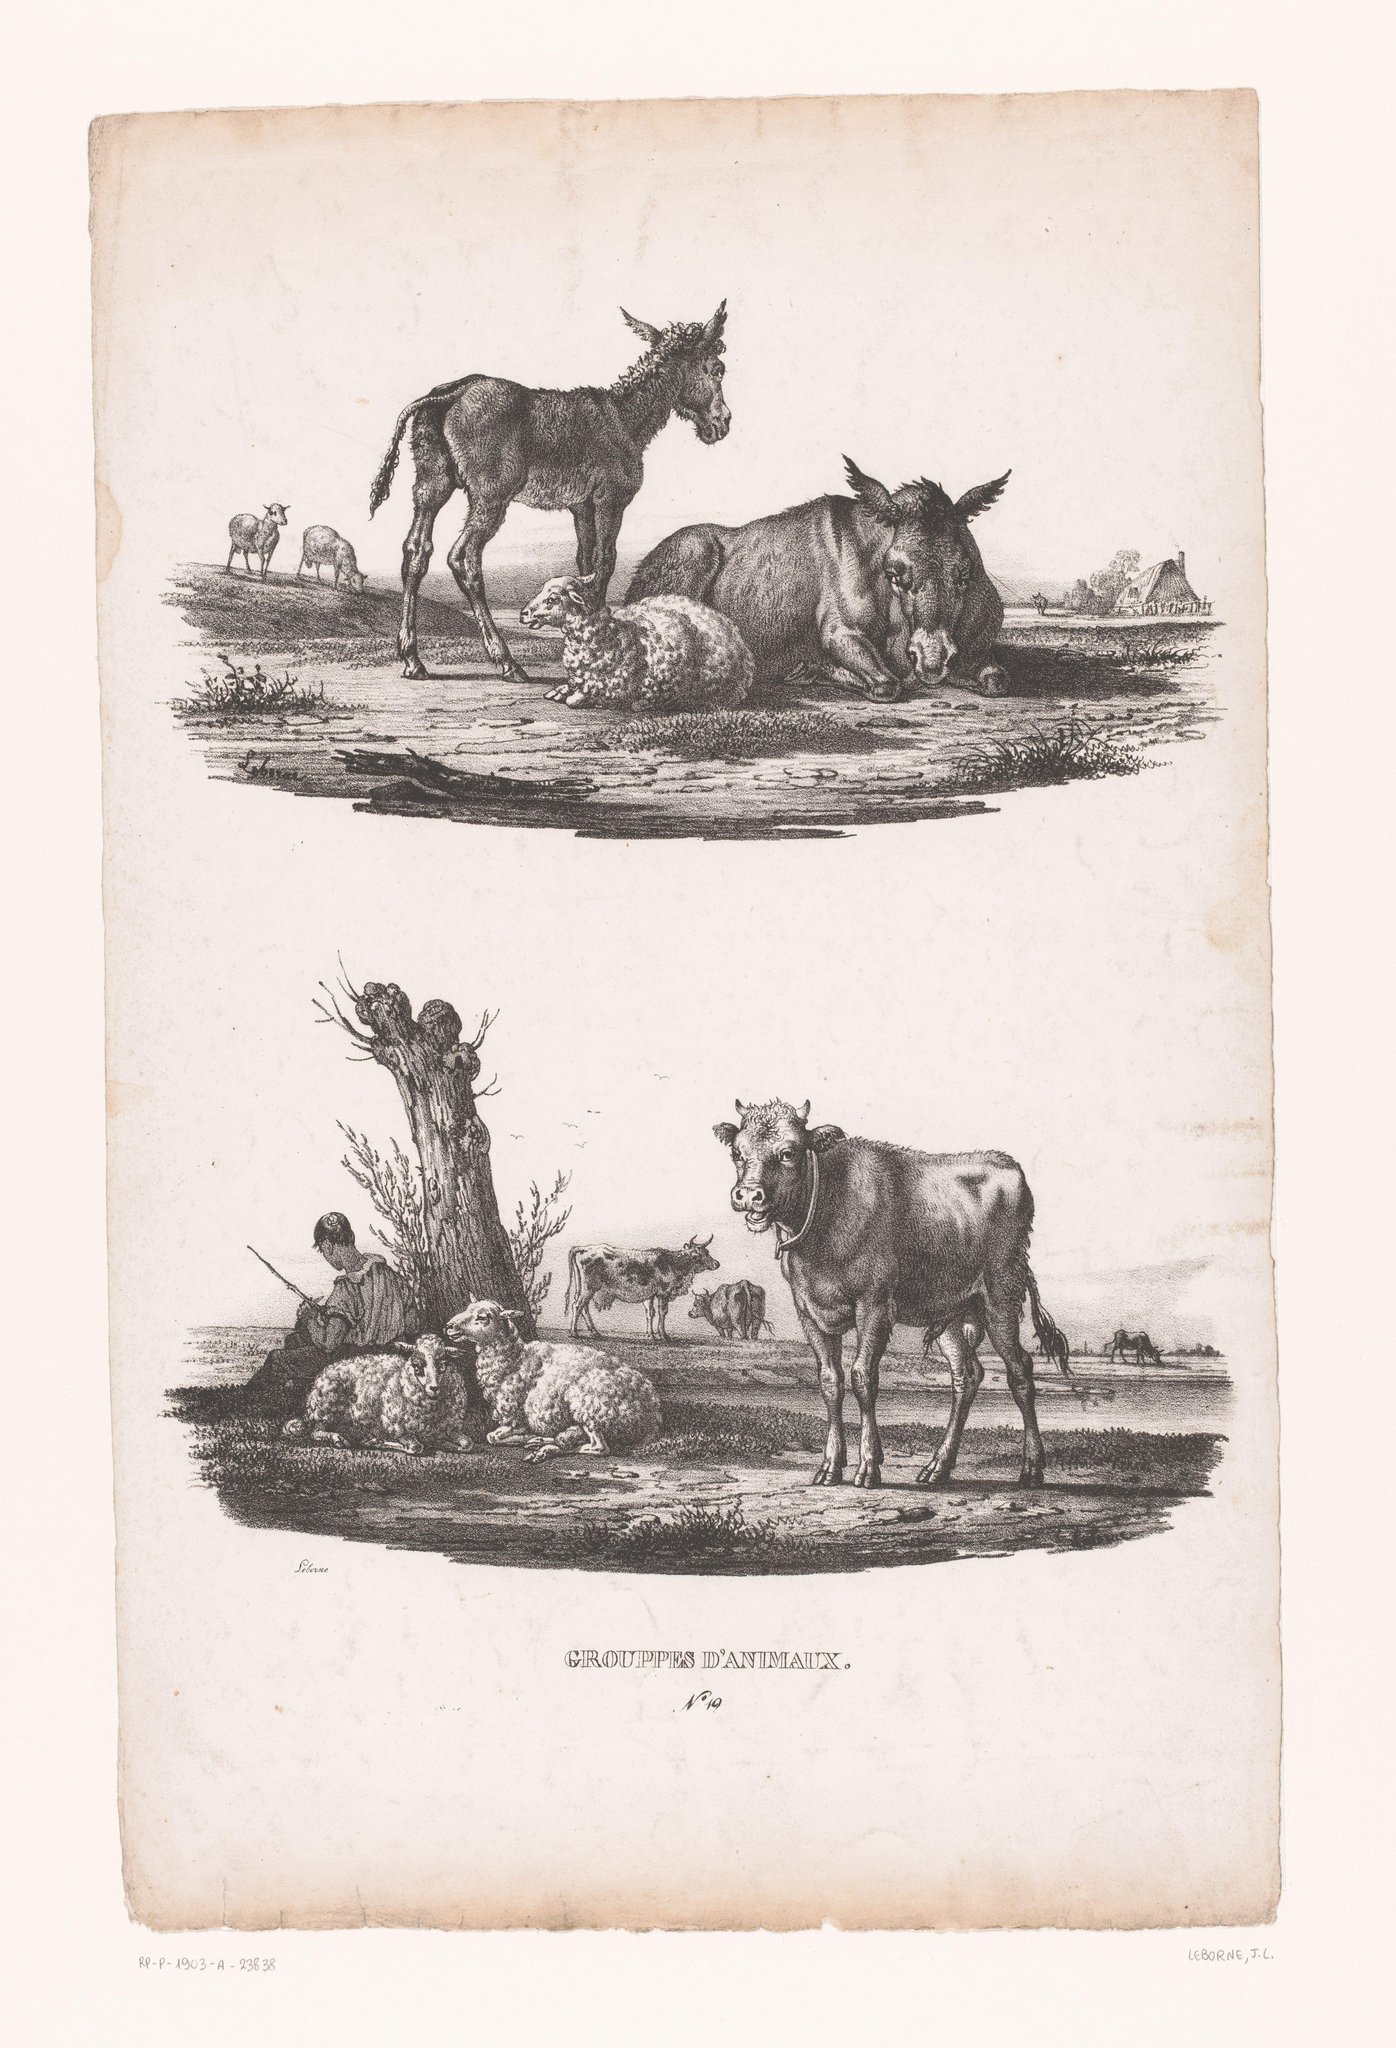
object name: print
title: Voorstellingen van groepen dieren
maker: joseph louis leborne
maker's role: painter, print maker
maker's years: 1796-1865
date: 1828-1829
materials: paper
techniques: lithograph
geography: paris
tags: ass, donkey, herding, herdsman, herdswoman, shepherd, shepherdess, cowherd, etc., sheep, bovine cattle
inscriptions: collector's mark: Lugt 2228a